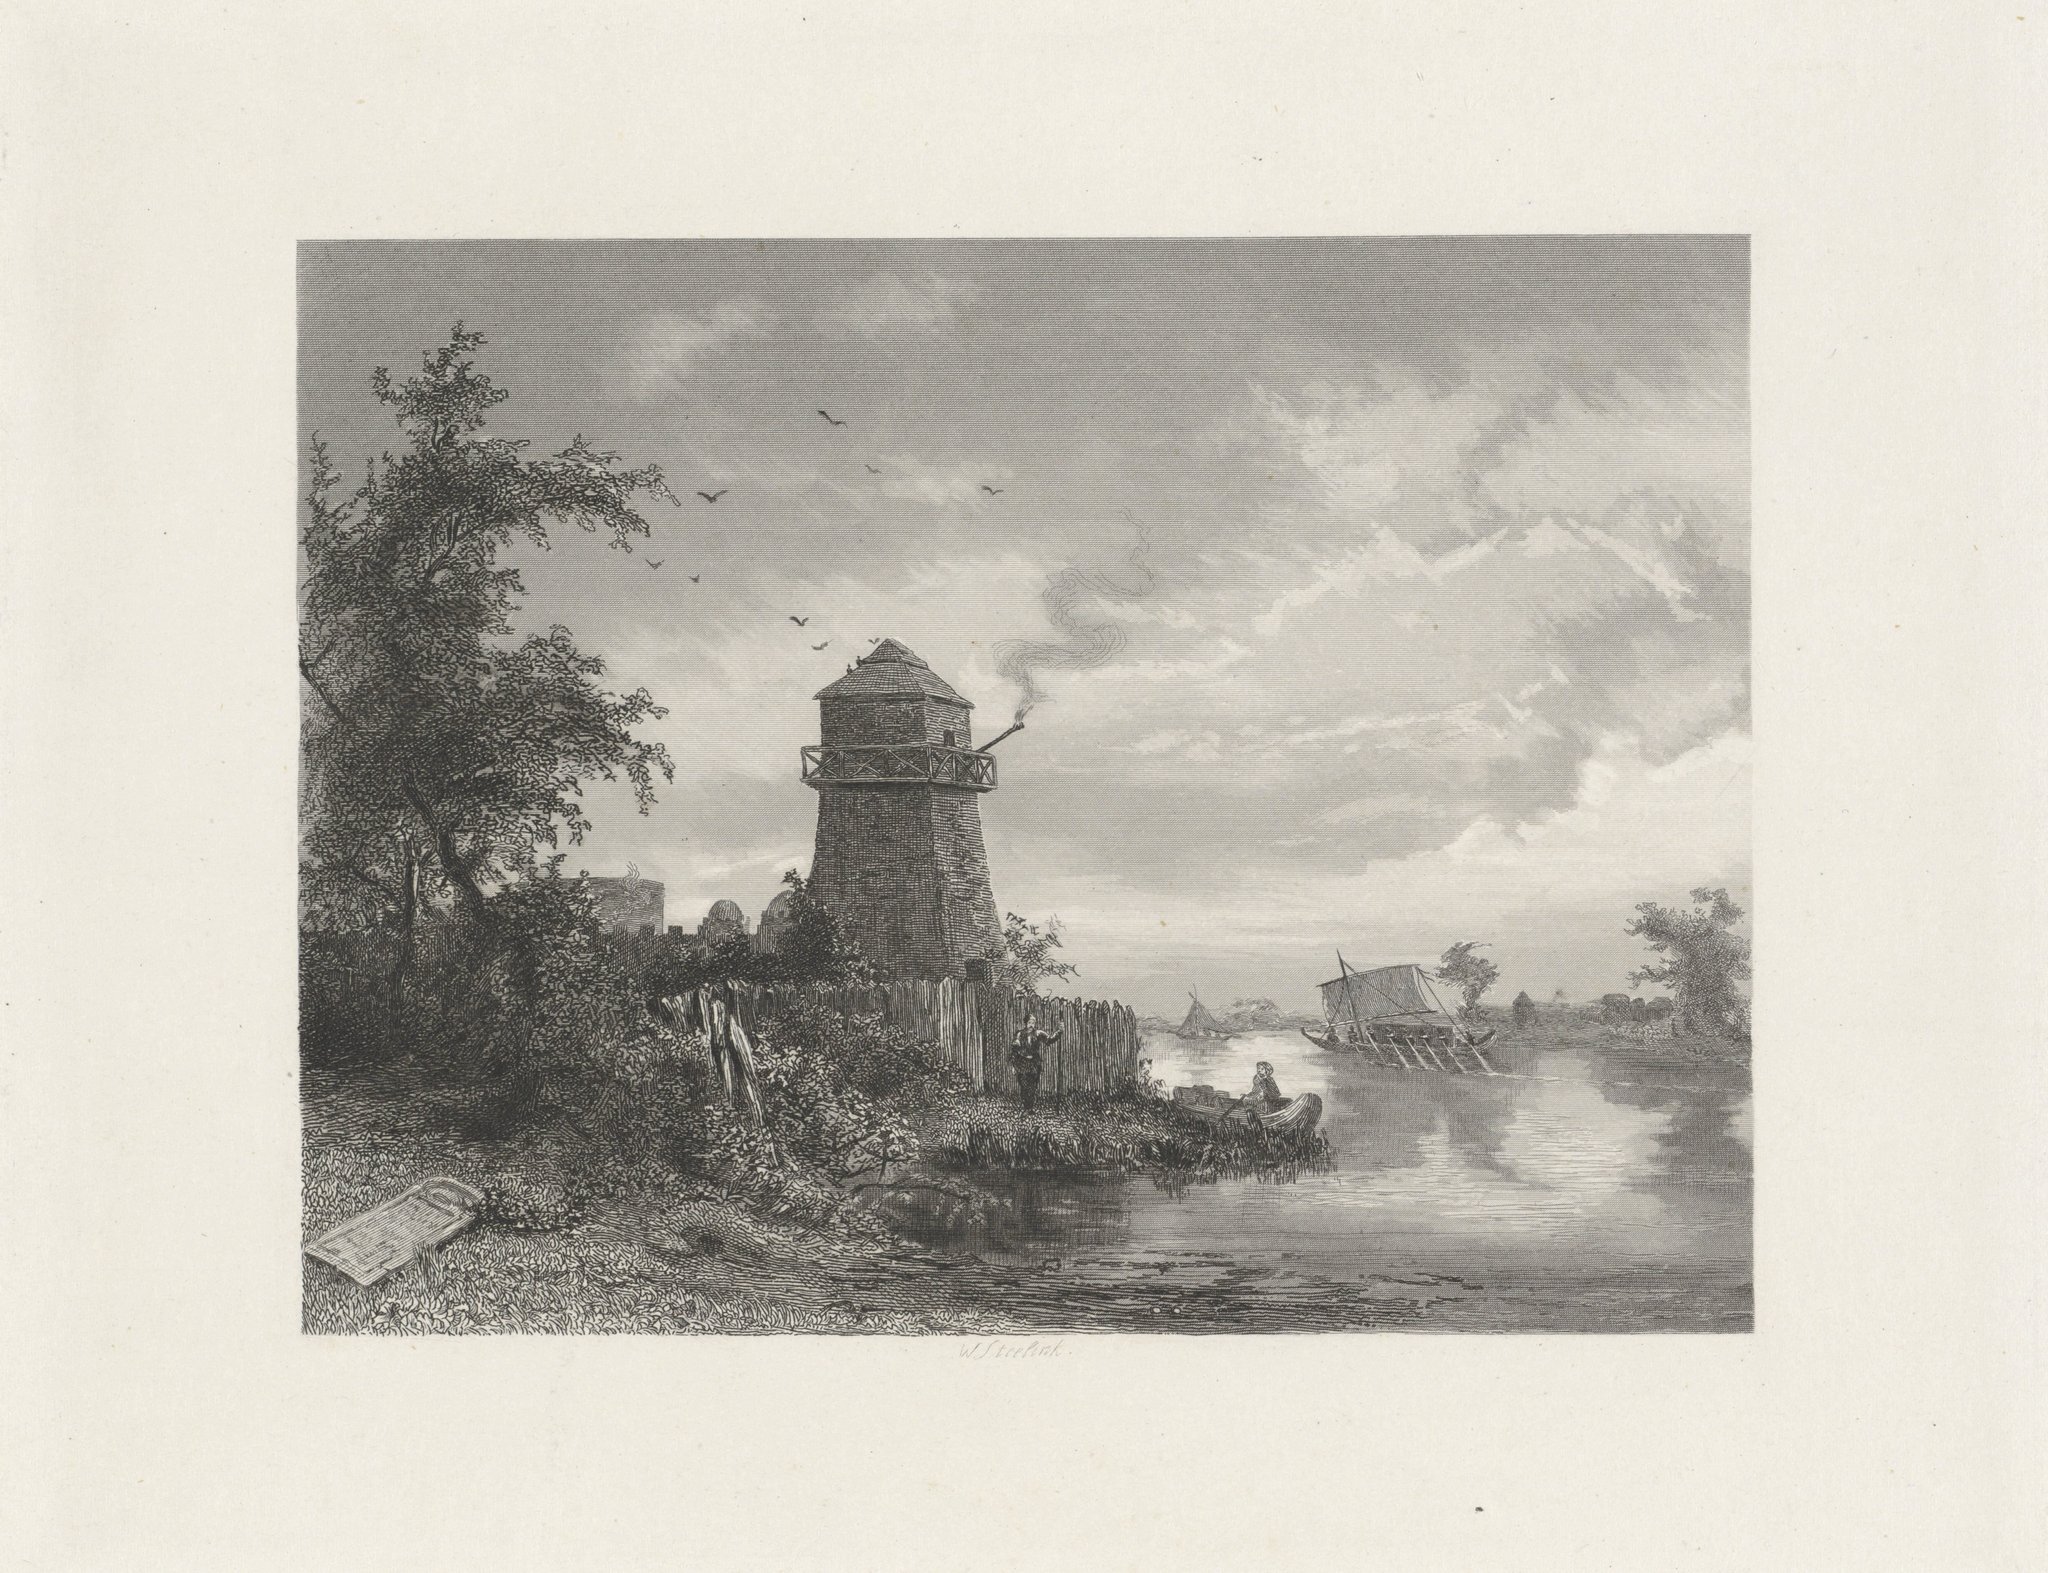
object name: book illustration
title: Toltoren te Utrecht, Romeinse tijd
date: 1865-1870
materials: paper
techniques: engraving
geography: amsterdam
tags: toll gate, utrecht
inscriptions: collector's mark: Lugt 2228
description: Illustratie voor: J. van Lennep en W. Moll en J. ter Gouw, Nederlands geschiedenis en volksleven in schetsen, A.W. Sijthoff, Leiden ca. 1870. Staalgravures naar de schilderijen van de Historische Galerij der Maatschappij Arti en Amicitiae. Muller rangschikt deze prent bij de 10e eeuw. In het boek illustreert de prent de hoogtij van de handel in Nederland tijdens het Romeinse tijdperk.